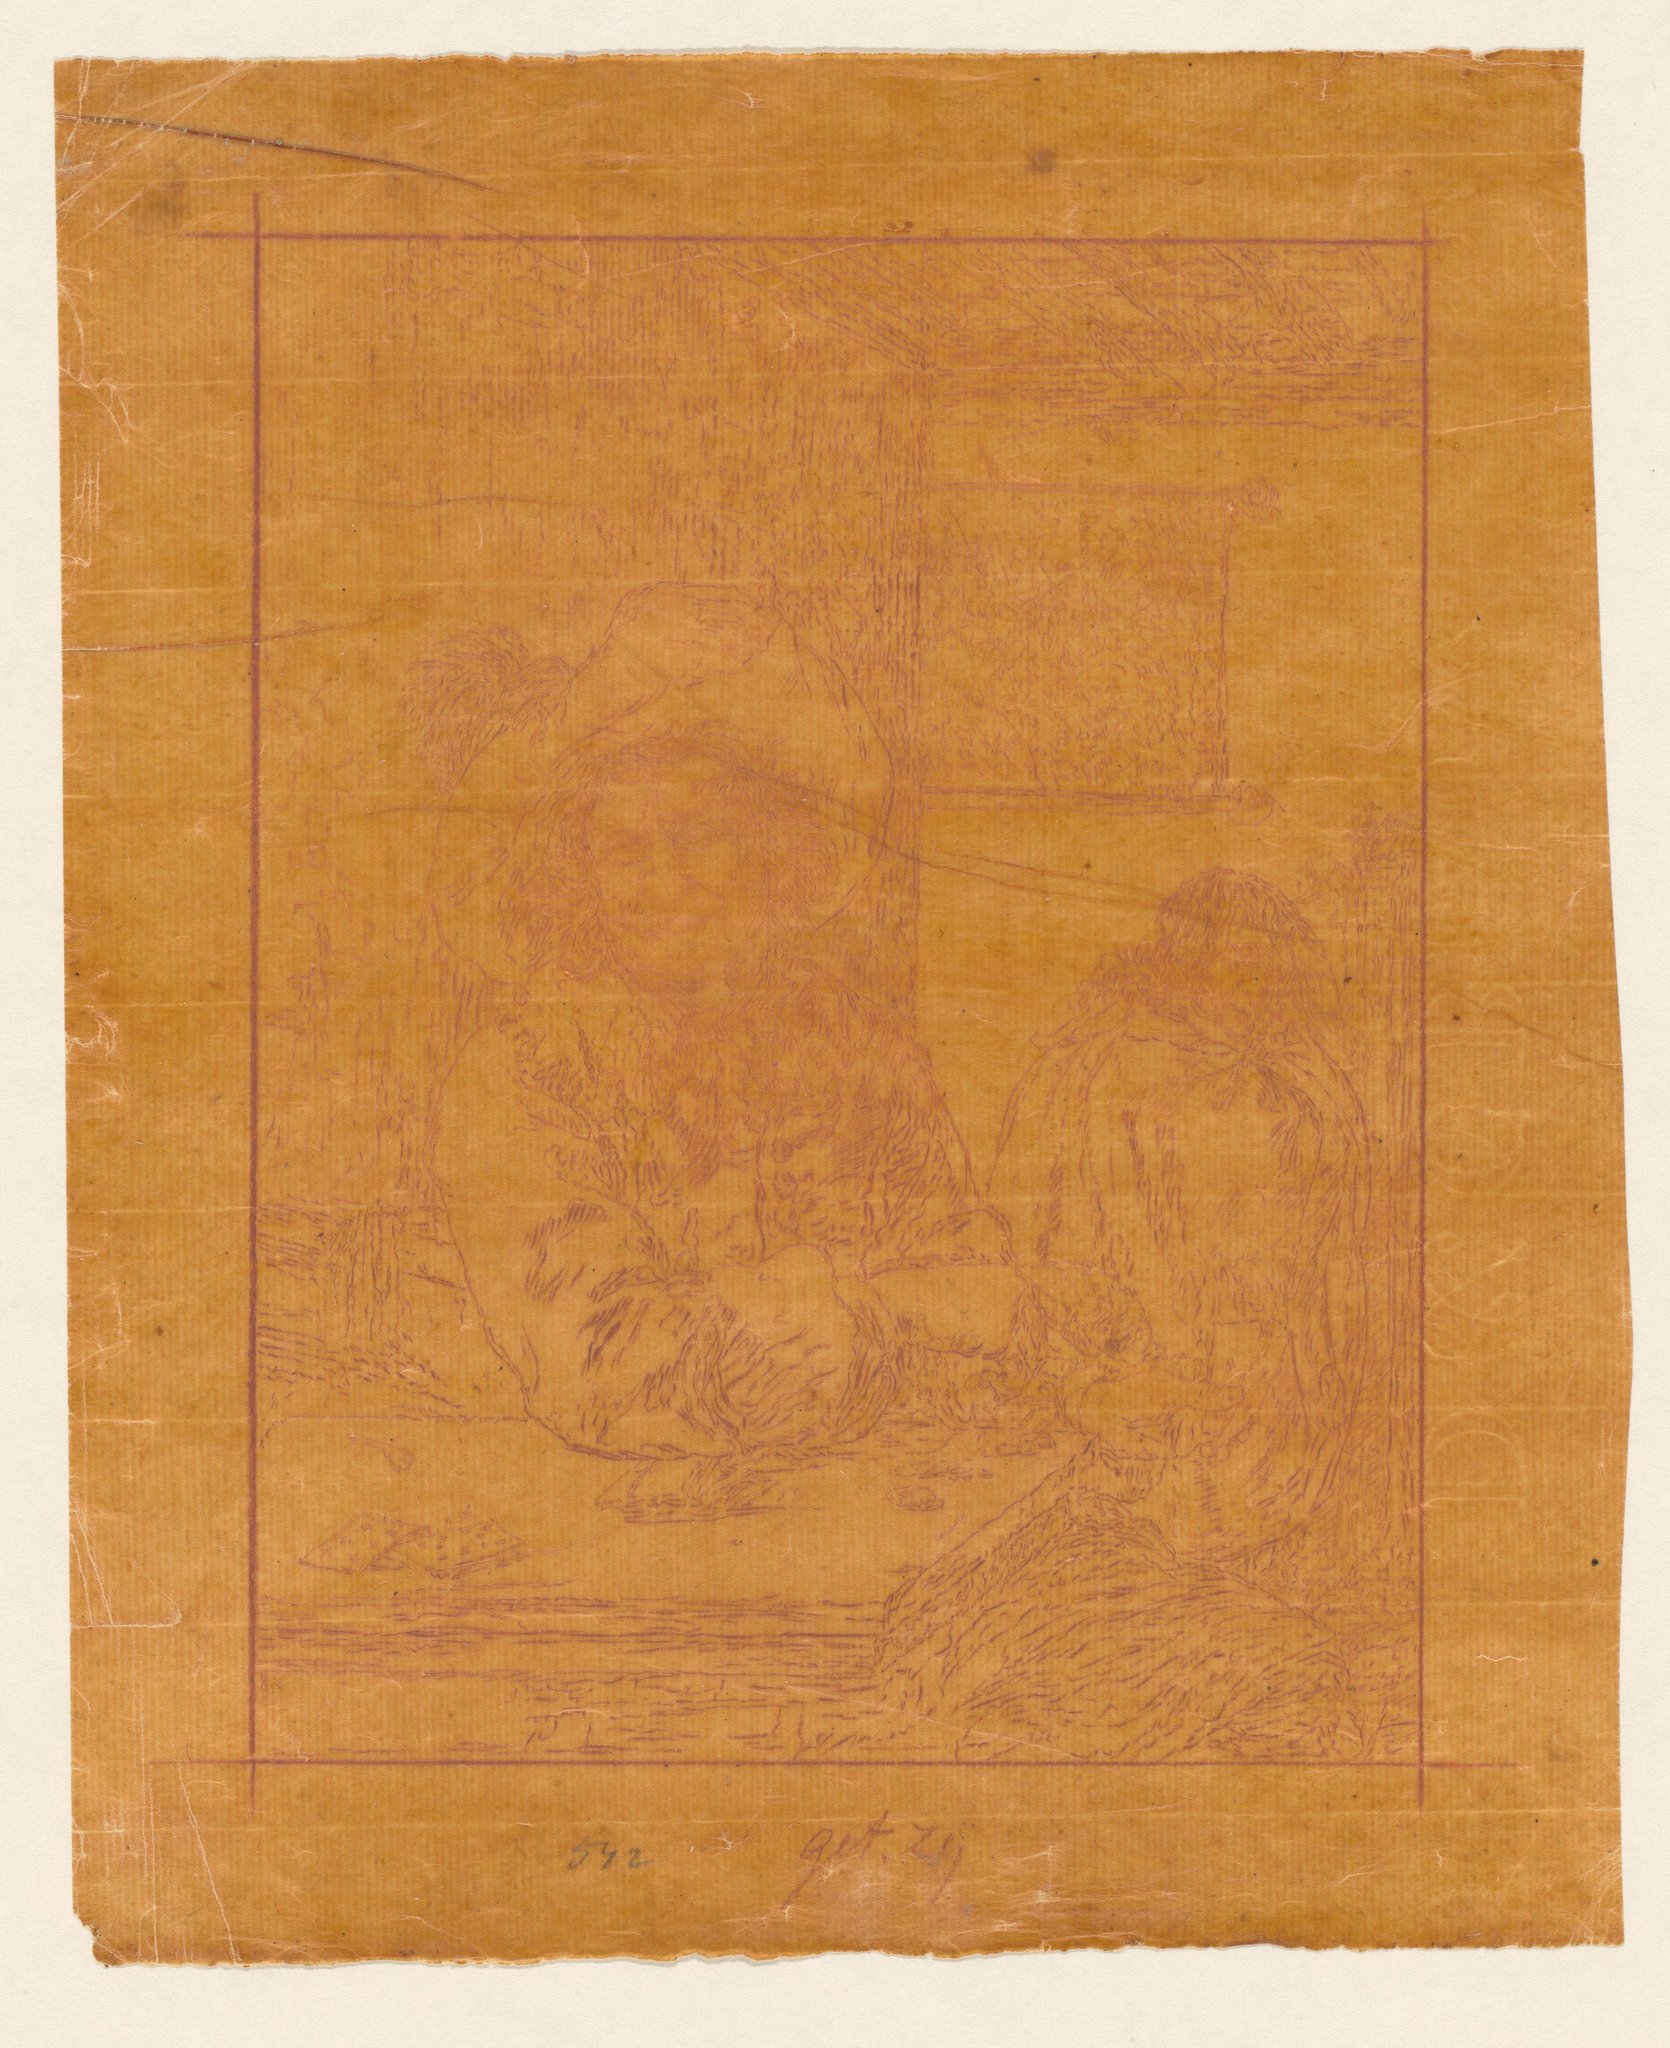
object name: tracing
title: Kaartspelers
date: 1777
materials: chalk, paper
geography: amsterdam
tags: playing-cards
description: Een kaartspeler met speelkaarten in de hand en op tafel. Op de achtergrond een man. De calque ligt los in een album, zie blad 26.